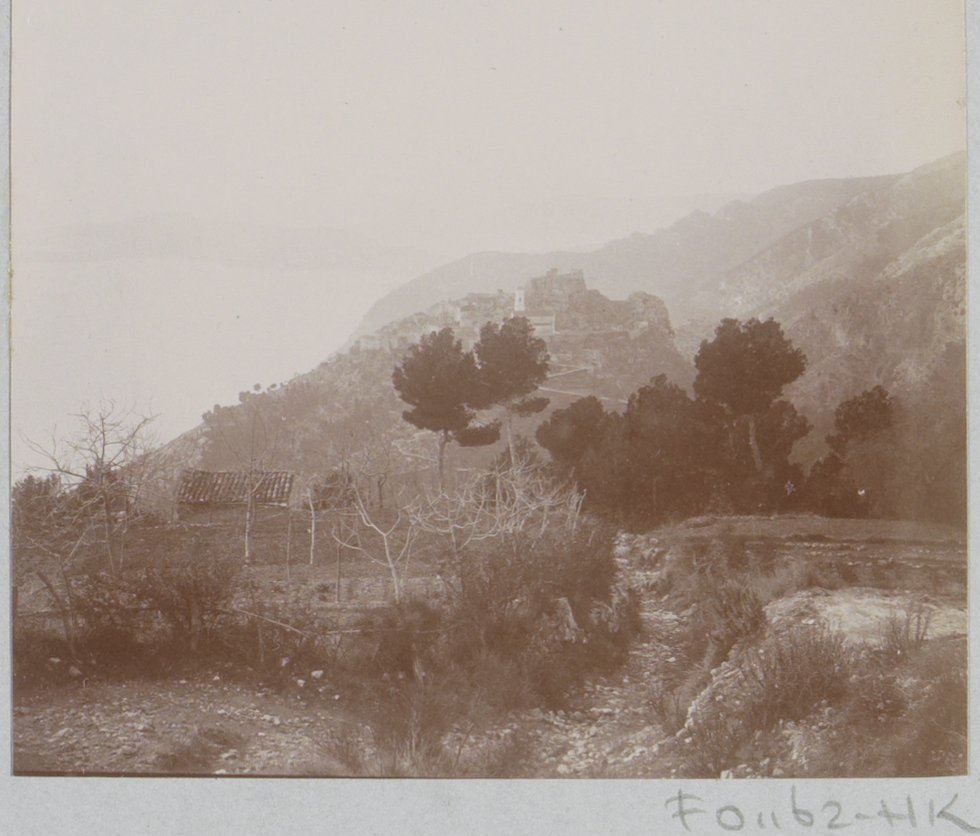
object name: photograph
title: Gezicht op een bergdorp, vermoedelijk in Zuid-Frankrijk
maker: Anonymous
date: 1905-1910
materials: paper, photographic support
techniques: gelatin silver print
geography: southern france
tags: prospect of city, town panorama, silhouette of city, mountains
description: Onderdeel van Fotoalbum van een Franse amateurfotograaf met bezienswaardigheden in Frankrijk, Zwitserland en Italië.